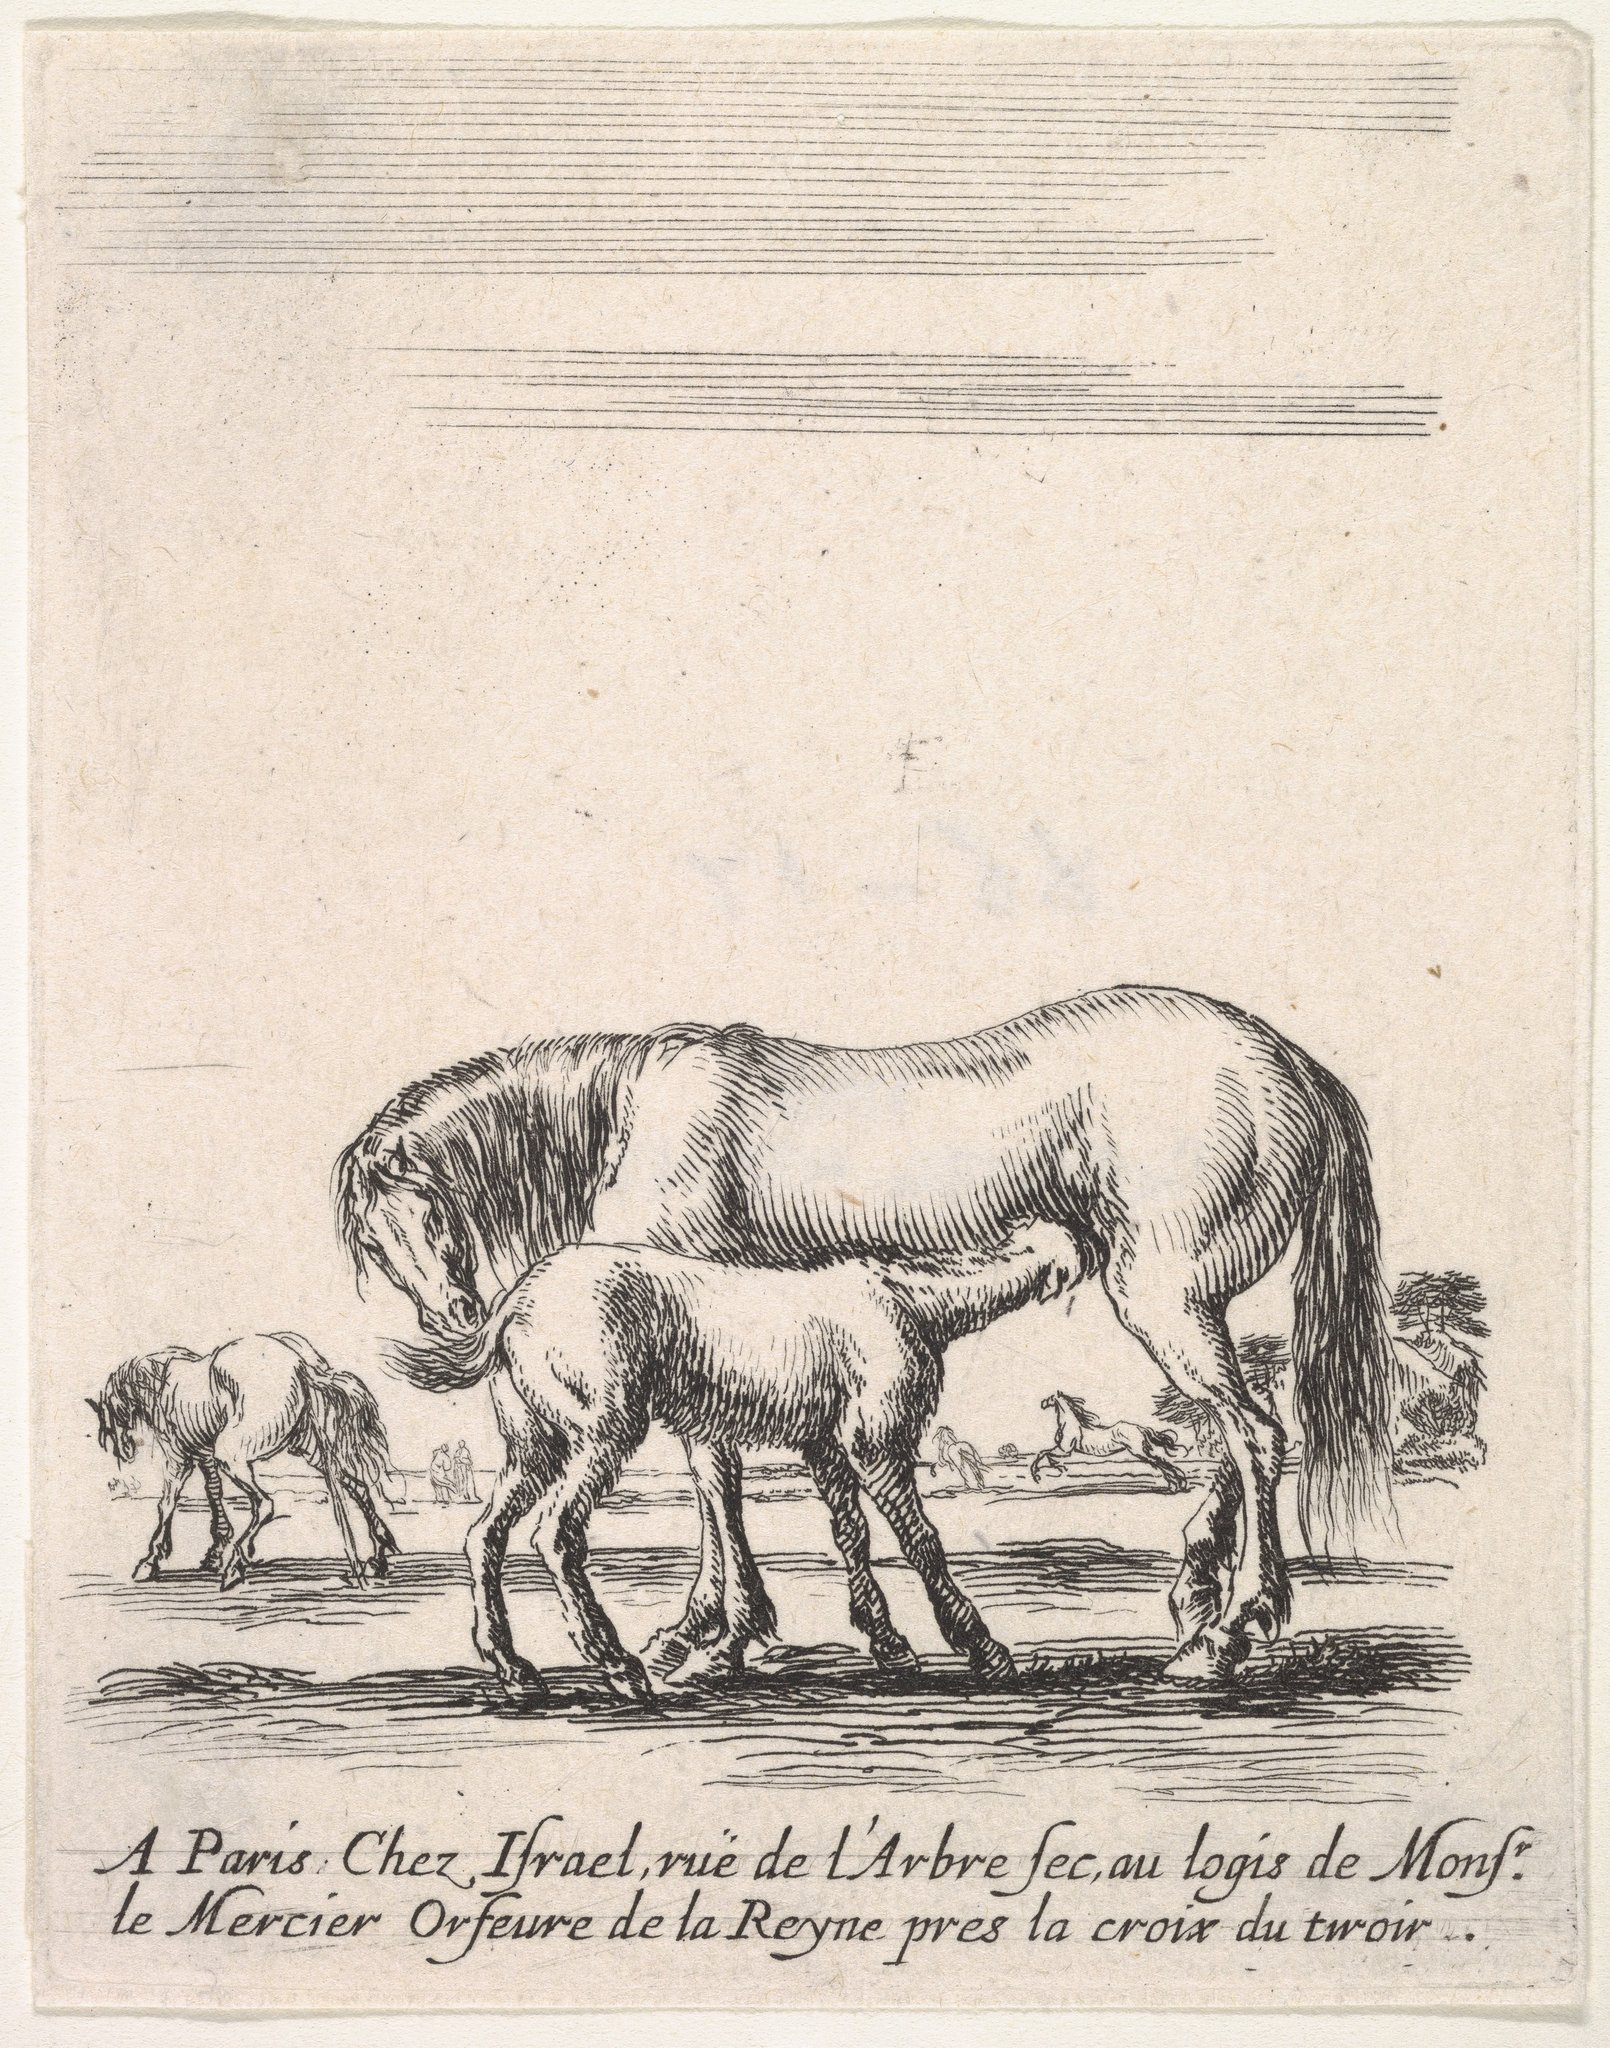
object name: print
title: Mare suckling a foal in center, another foal urinating in back left, other horses in the background, from "Various cavalry exercises" (Diverses exercices de cavalerie)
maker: stefano della bella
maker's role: artist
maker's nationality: italian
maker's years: 1610-1664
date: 1642-1645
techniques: etching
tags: horses